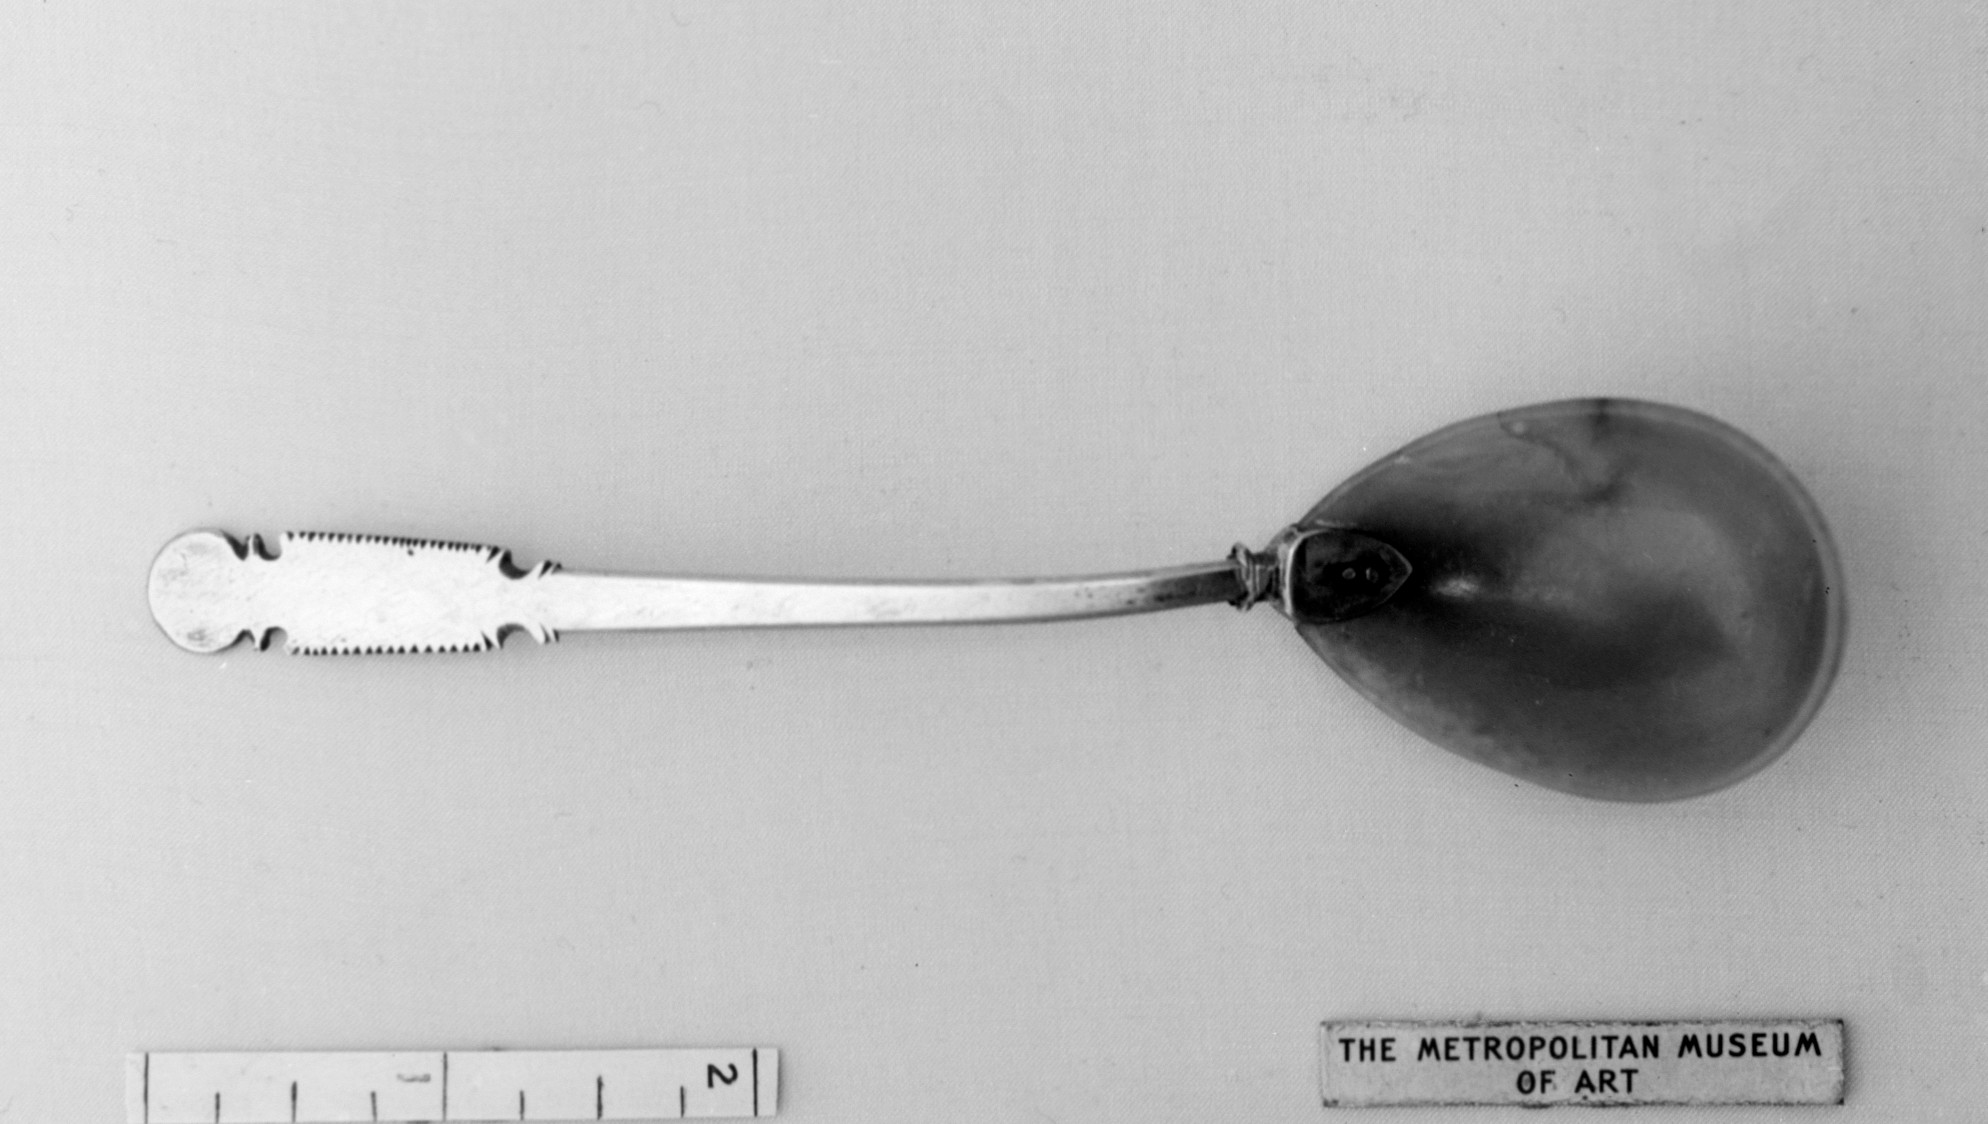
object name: spoon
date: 1801-1900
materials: jade, silver